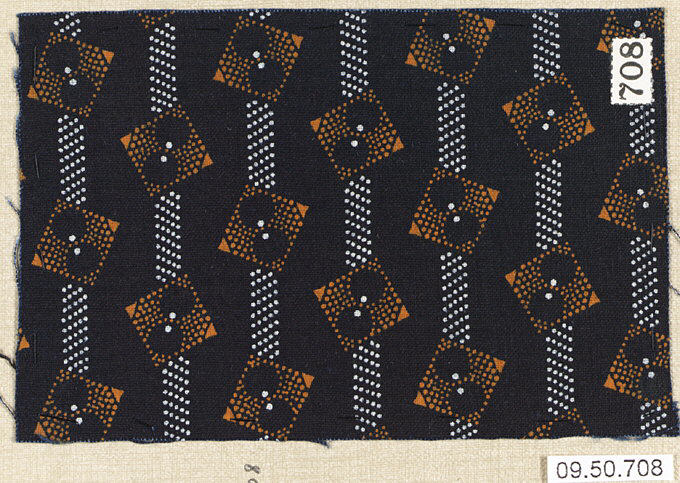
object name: piece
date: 1801-1900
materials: cotton